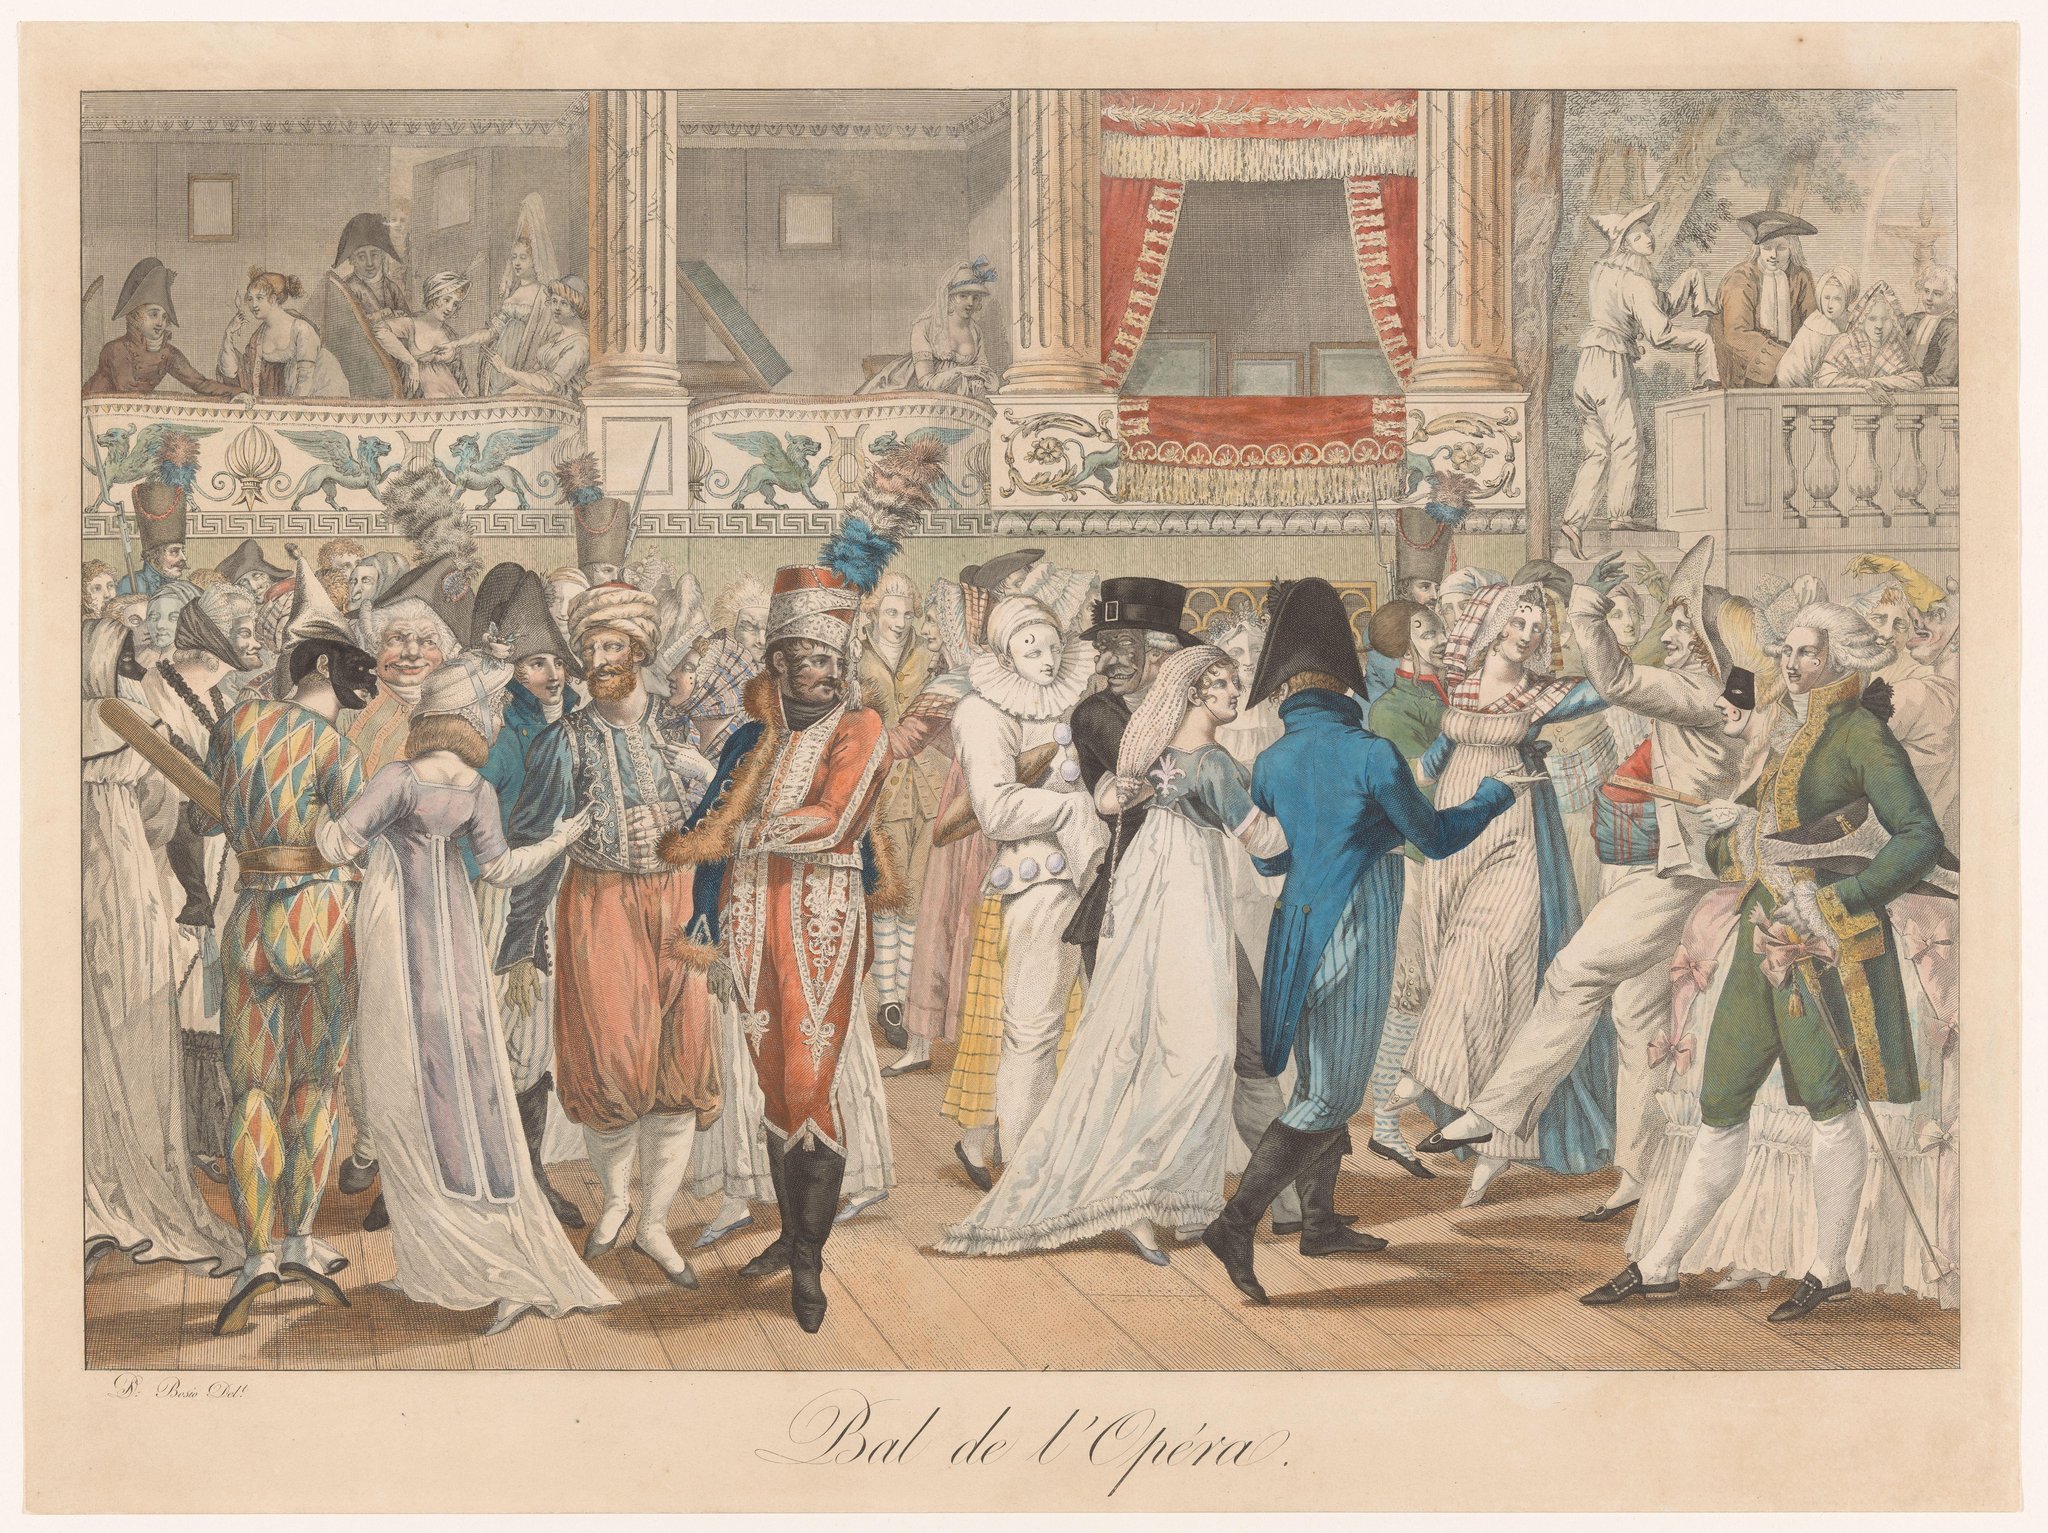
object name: print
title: Cinq tableaux de costumes Parisiens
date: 1804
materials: paper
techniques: etching, hand coloring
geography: france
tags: masquerade, masked ball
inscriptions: collector's mark: Lugt 2228, collector's mark: Lugt 2760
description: Onderdeel van een serie getiteld 'Cinq tableaux de costumes Parisiens' uit 1804 voor de Journal des Dames.